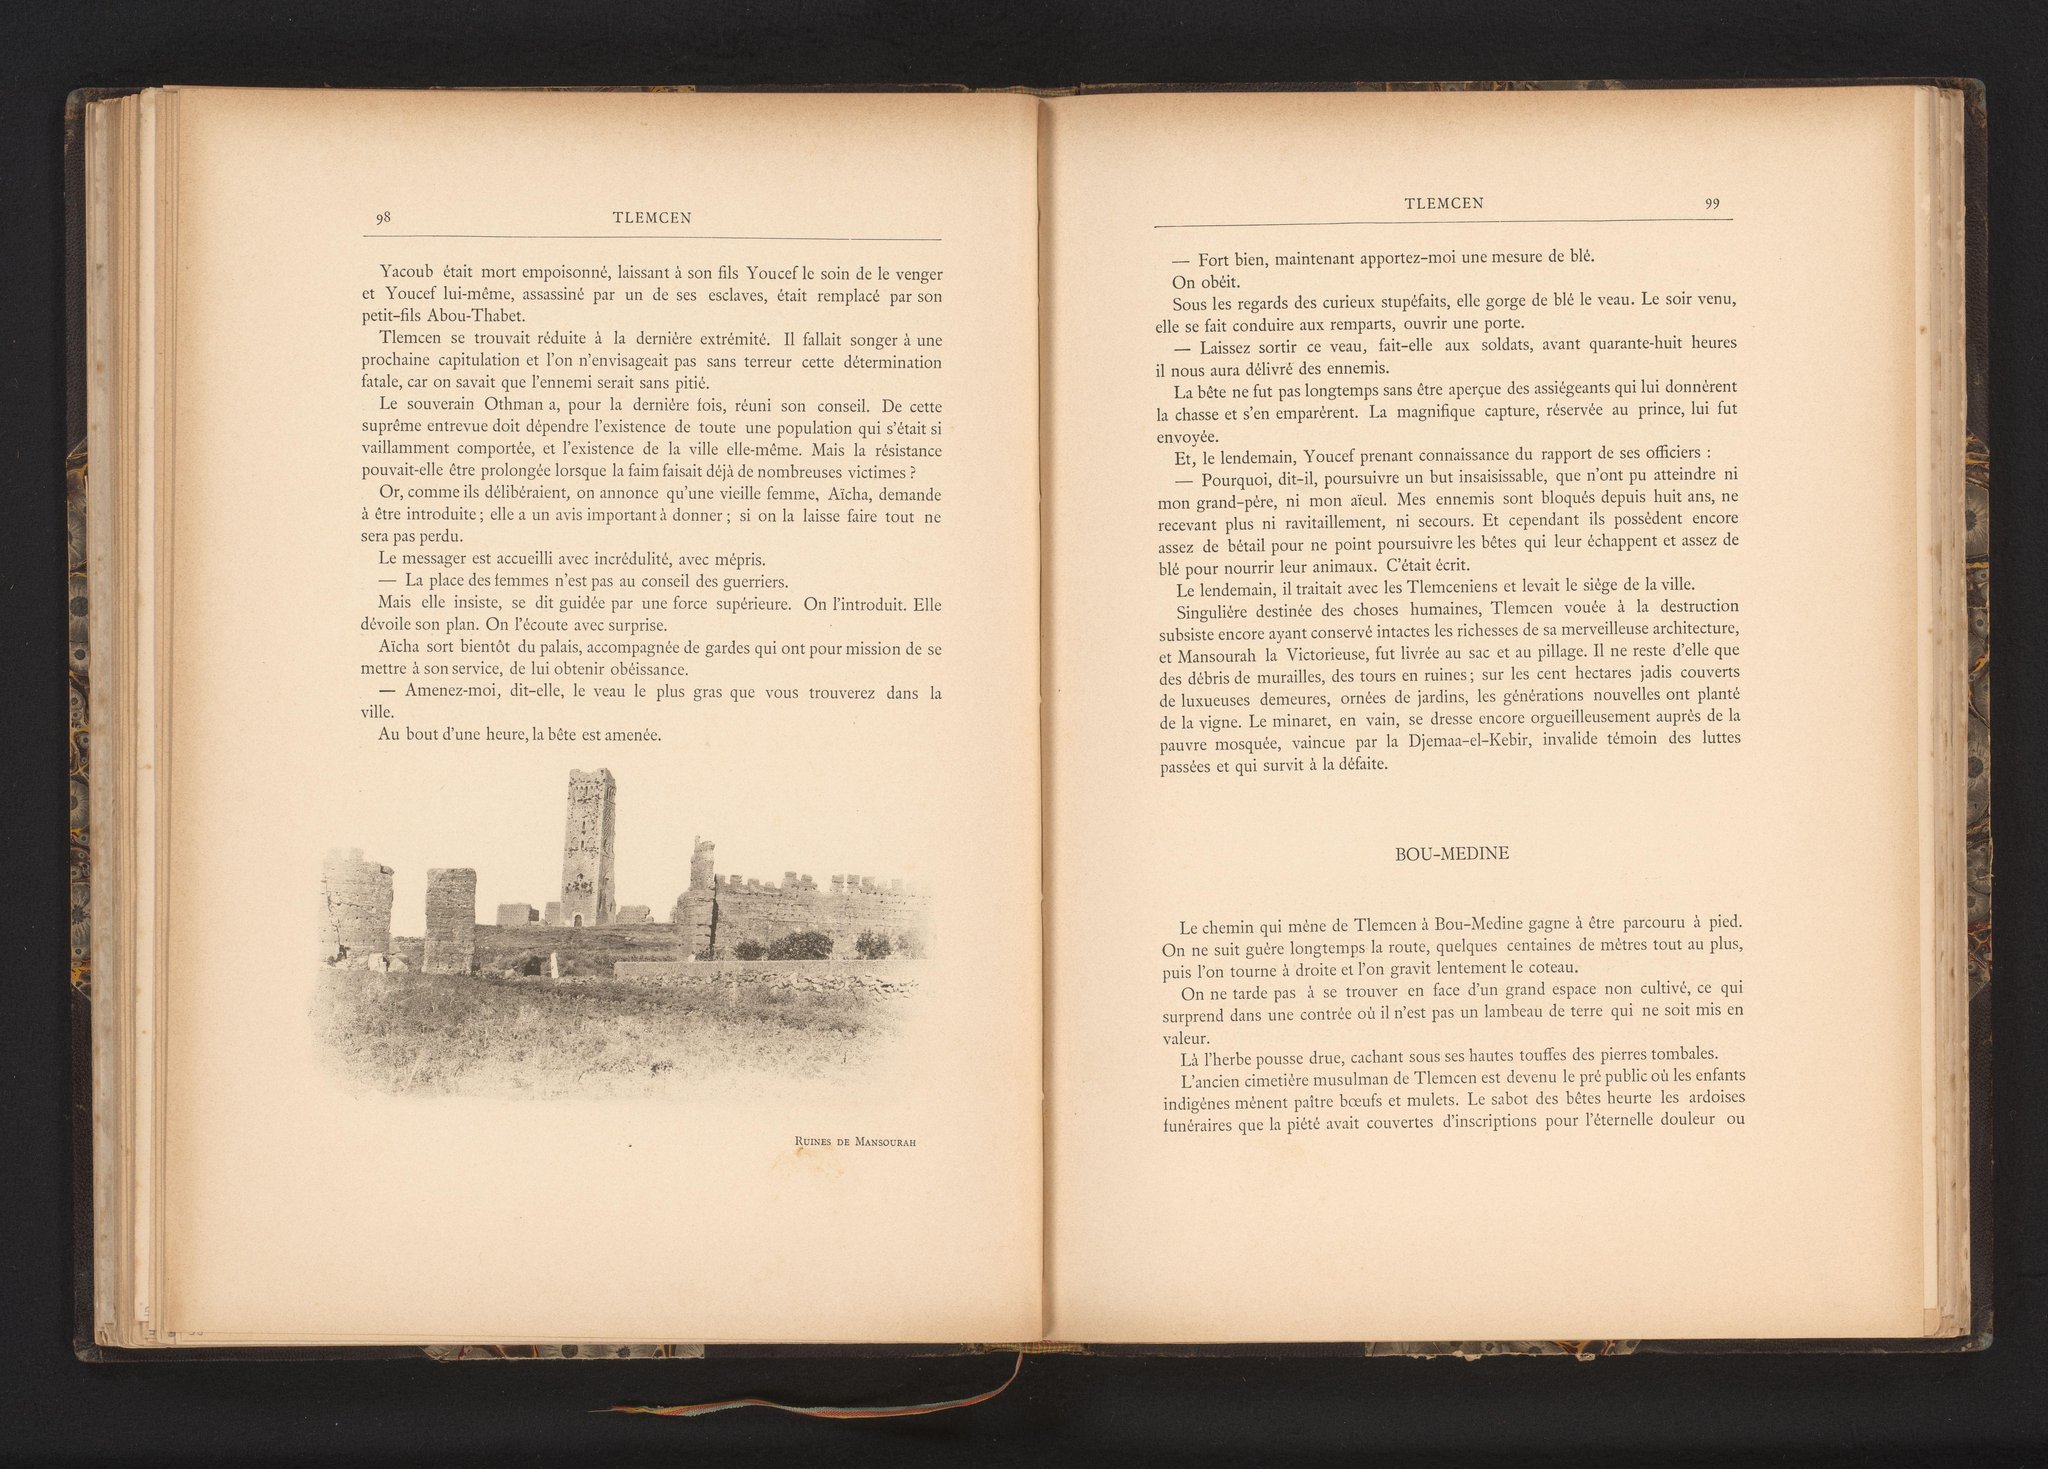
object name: page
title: Gezicht op de ruïnes van Mansourah bij Tlemcen, Algerije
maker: jules gervais-courtellemont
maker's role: fotograaf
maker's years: 1863-1931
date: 1888-1893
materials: paper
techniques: photograph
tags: ruin of a building ~ architecture